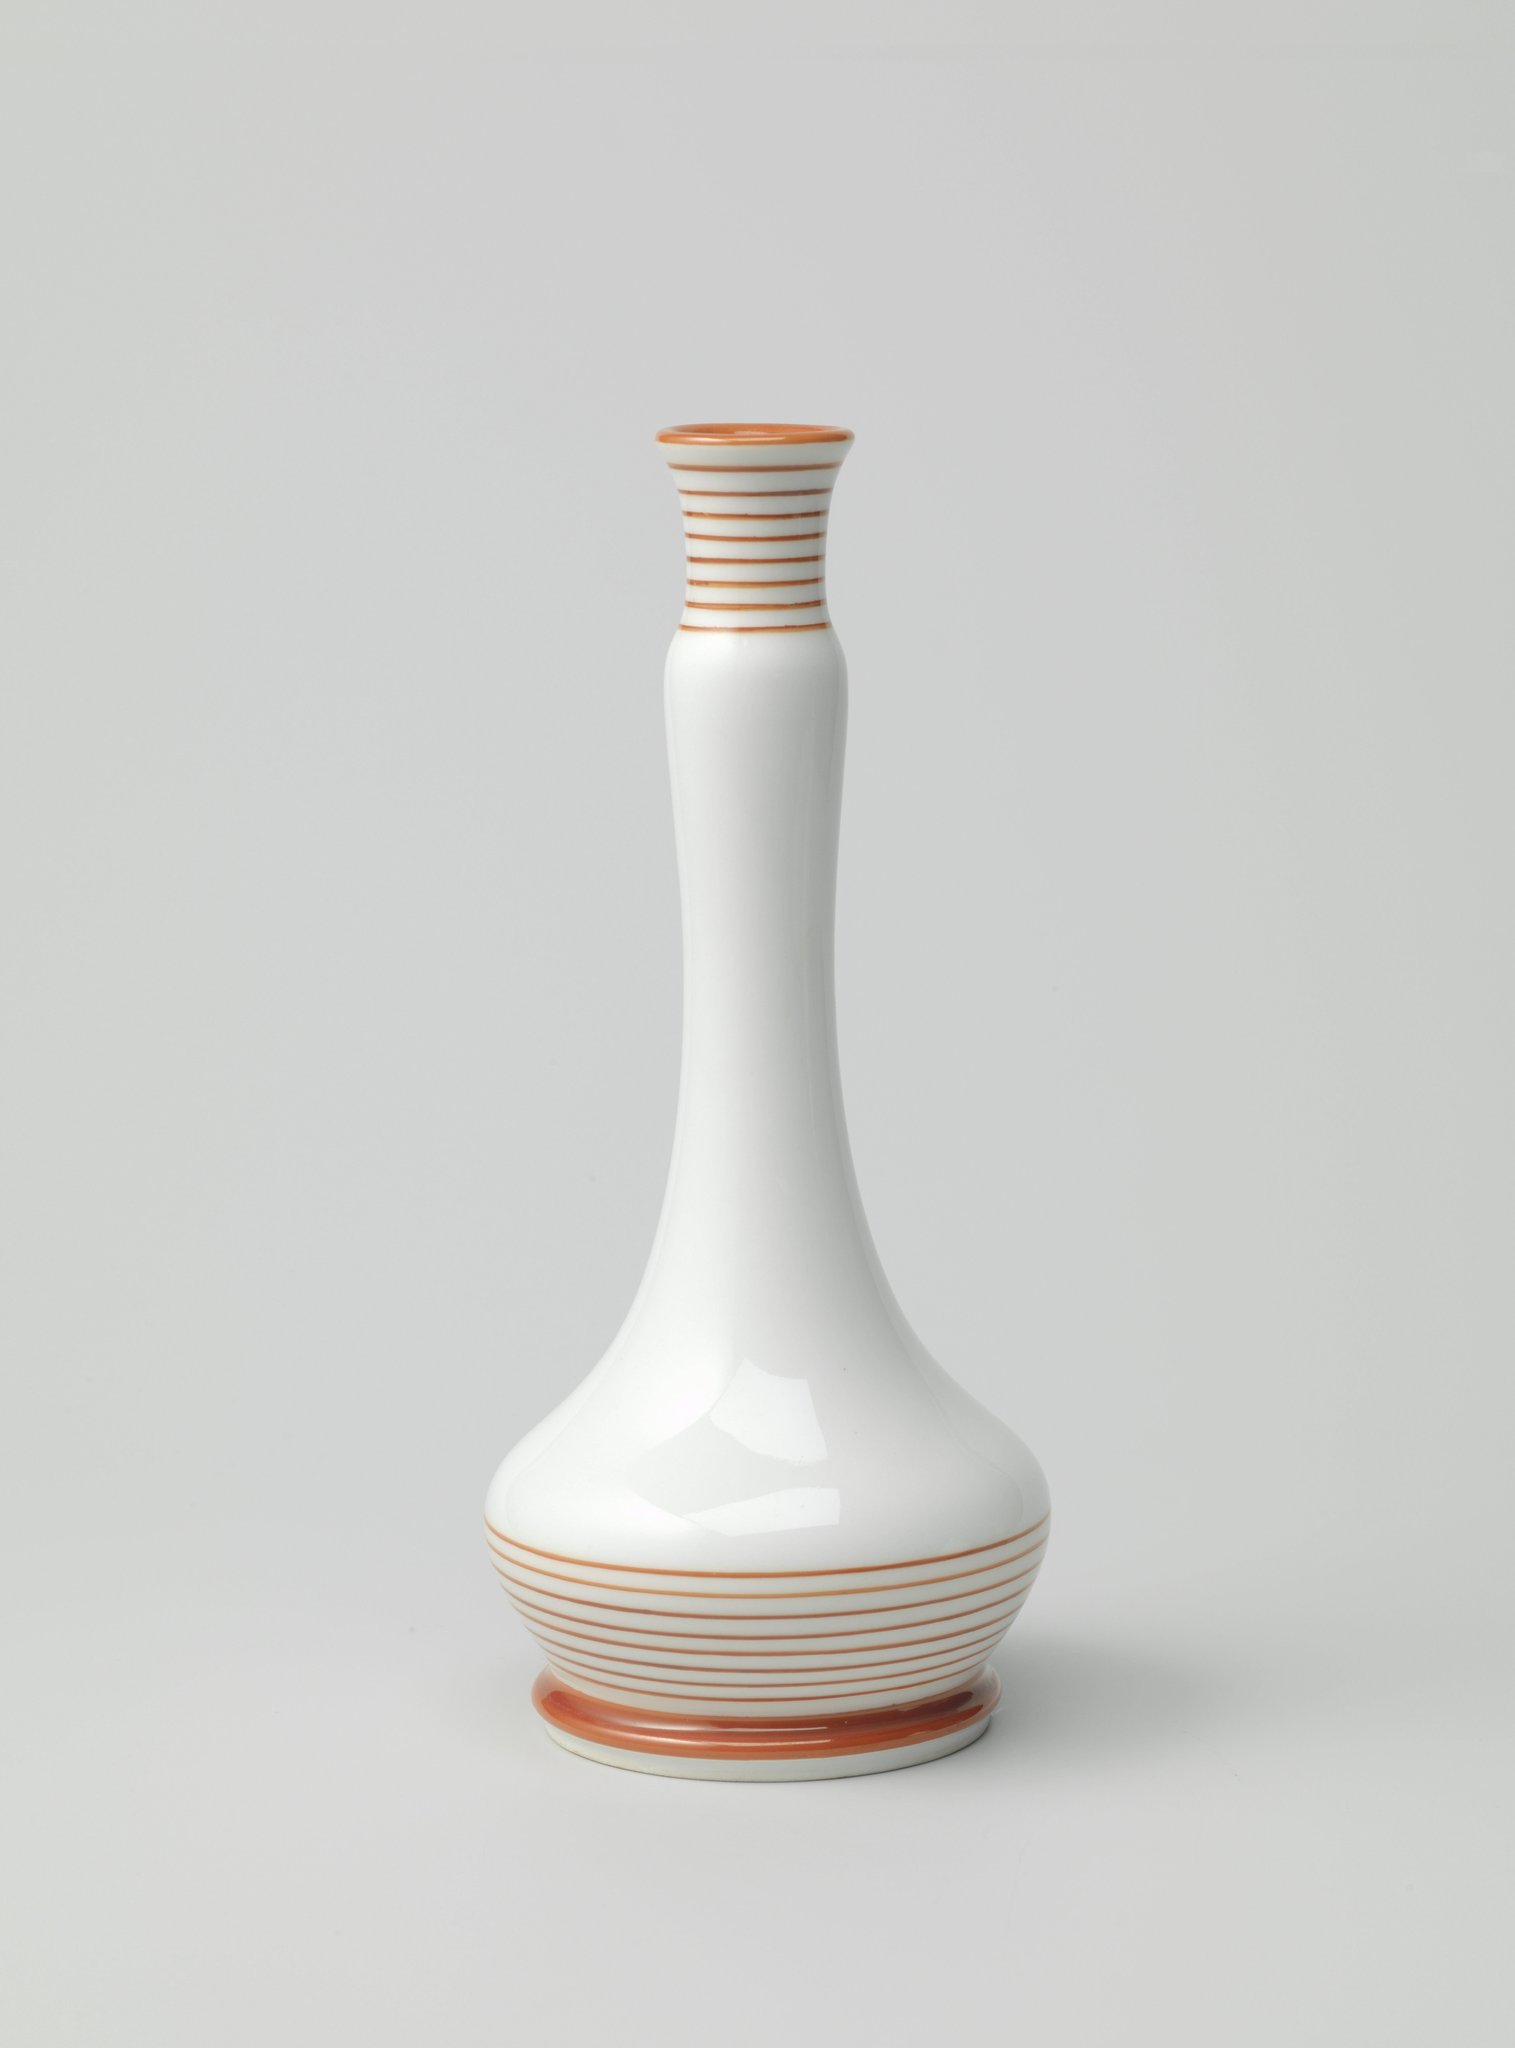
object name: vase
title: Vase with red borders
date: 1925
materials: glaze, paint, porcelain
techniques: firing, forming, vitrification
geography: berlin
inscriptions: mark: ‘scepter/ 25/85/ rode rijksappel met K.P.M./ Z.[...]/ M’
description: Vaas van porselein met een laag, gedrukt eivormig lichaam en lange, smalle nek. Beschilderd in onderglazuur rood. Net onder de spreidende rand van de nek een verdunning met smalle rode banden; op de buik dezelfde decoratie. De voet en de rand met een bredere rode band. Gemerkt op de onderzijde met de scepter, de cijfers 25/85, de rode rijksappel met K.P.M., de jaarletters Z.[...] en de letter M. Art Nouveau.